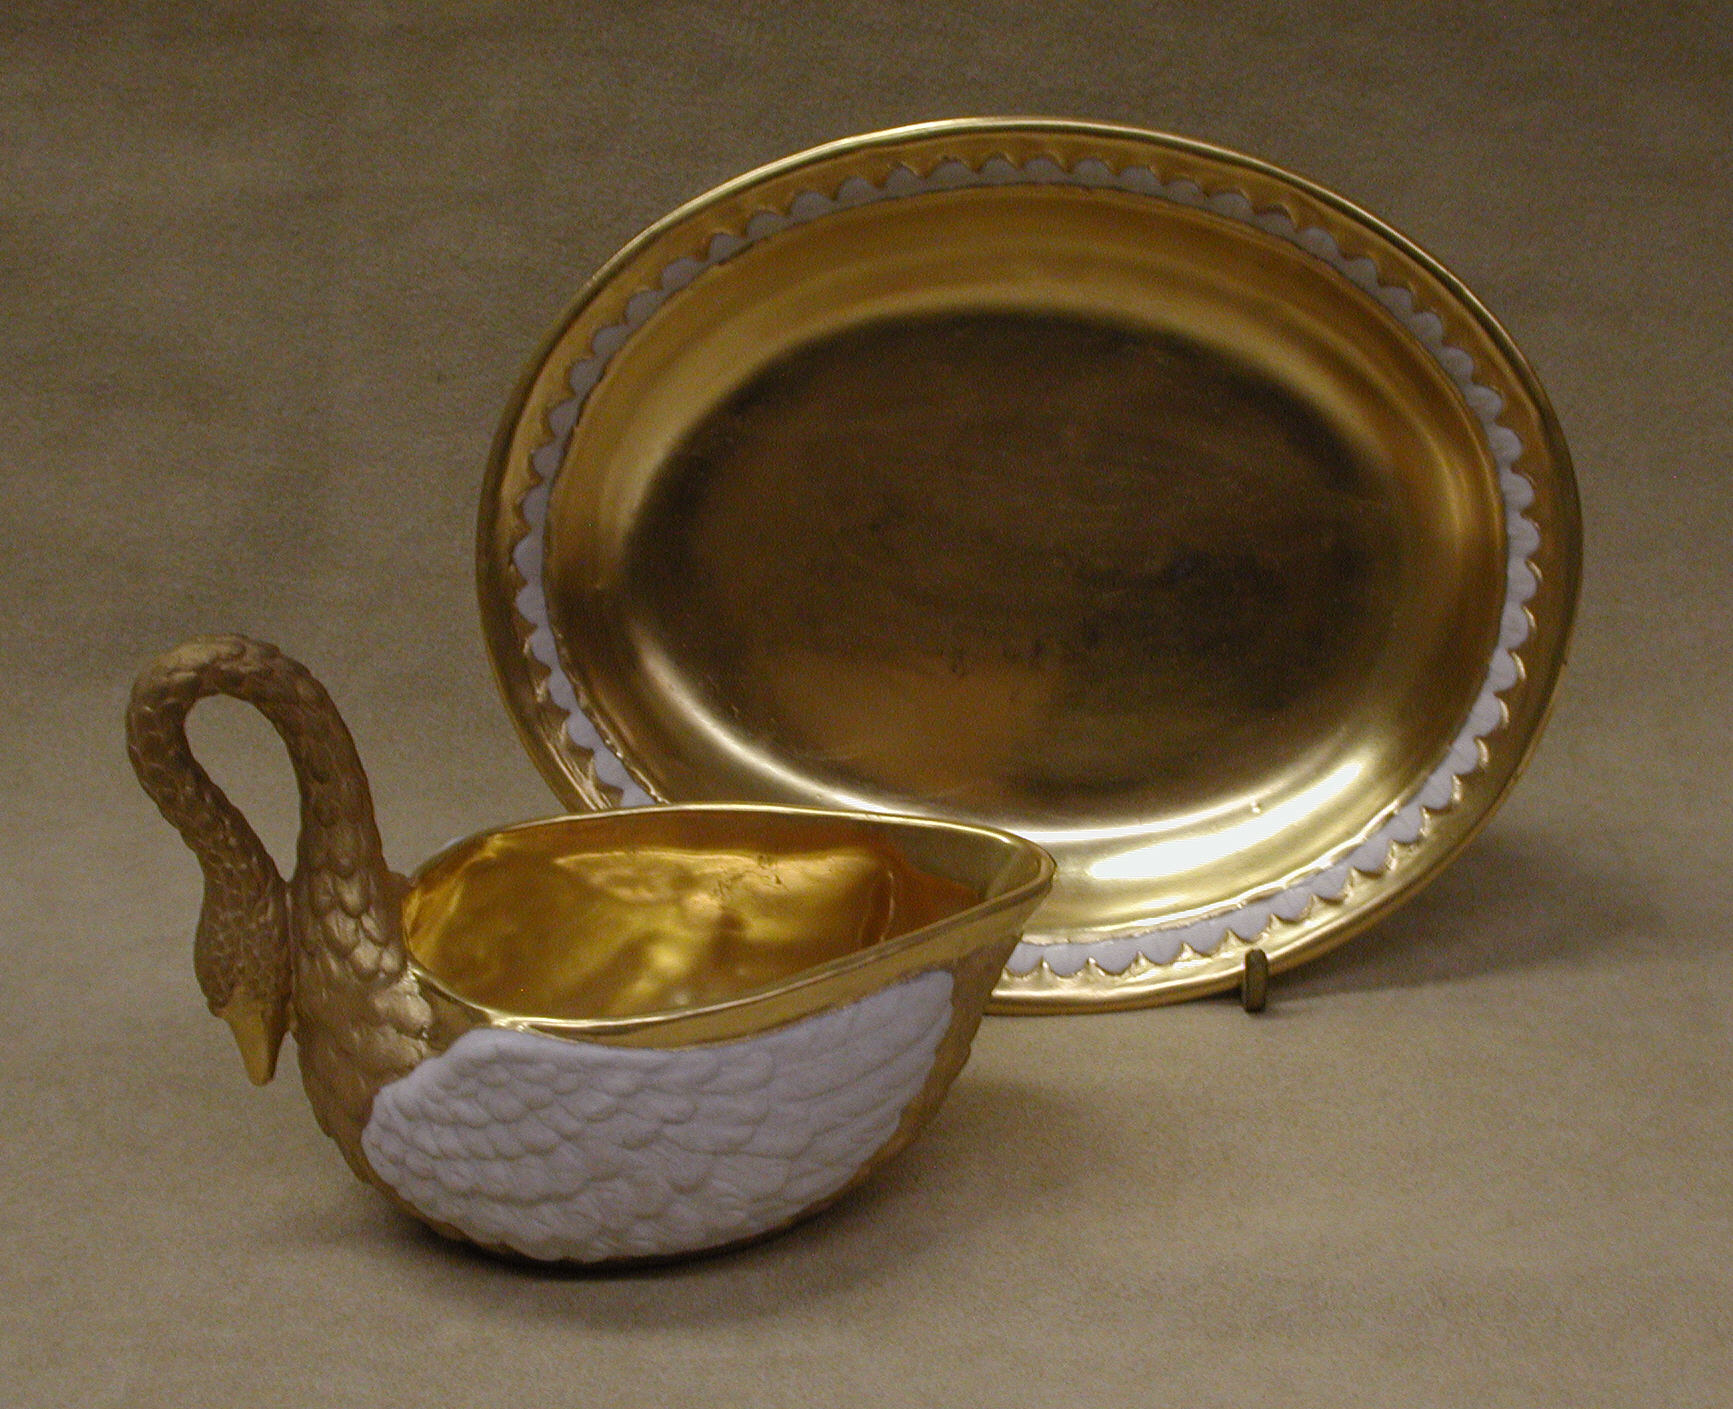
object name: sauceboat and stand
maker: zurich pottery and porcelain factory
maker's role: factory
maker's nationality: swiss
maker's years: 1763-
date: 1801-1833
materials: hard paste porcelain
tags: swans